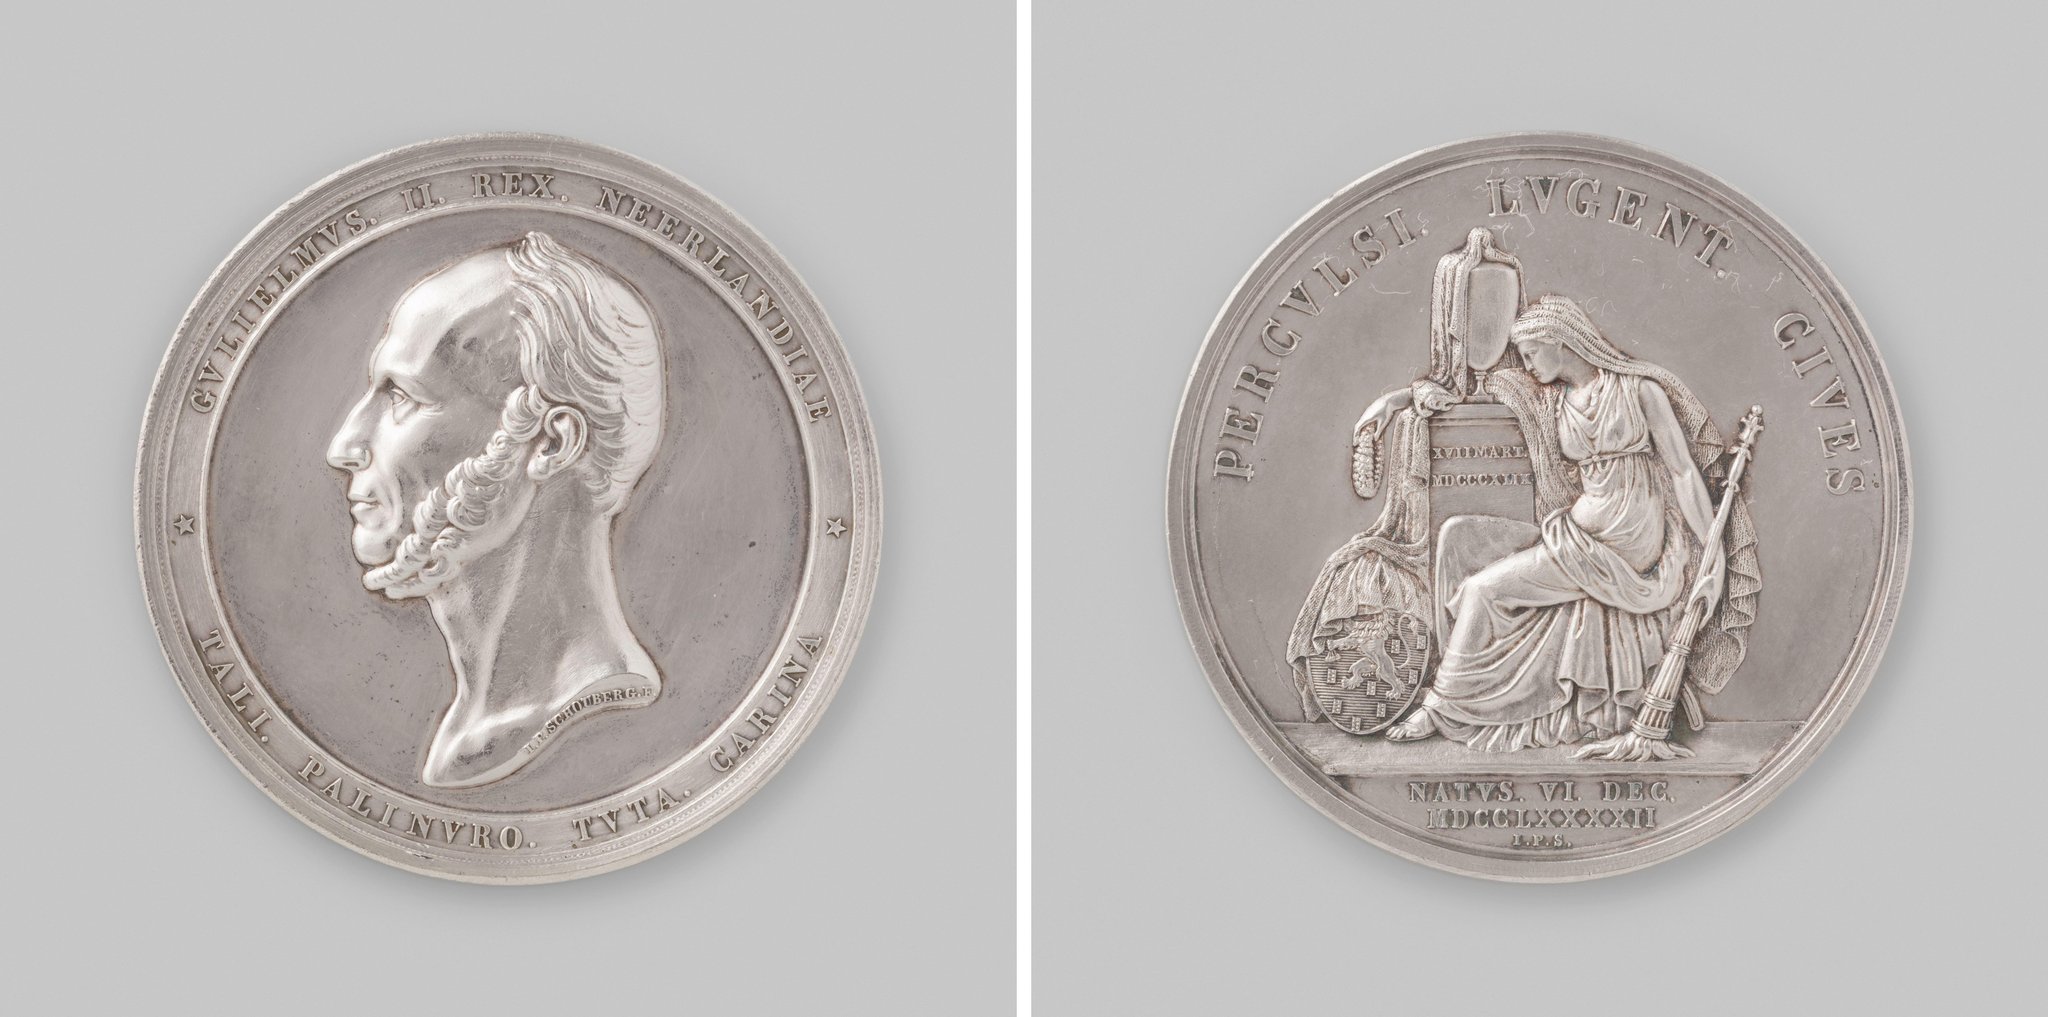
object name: history medal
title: Overlijden van Willem II, koning der Nederlanden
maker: johannis petrus schouberg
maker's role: die cutter, draughtsman, print maker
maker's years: 1798-1864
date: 1849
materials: silver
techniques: striking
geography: utrecht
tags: william ii of the netherlands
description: Zilveren penning. Voorzijde: borststuk man binnen omschrift. Keerzijde: gesluierde vrouw met omgekeerde,gedoofde fakkel in linker- en krans in rechterhand, zit rouwend naast sokkel waaroplijkbus staat, waarom zij haar rechterarm slaat binnen omschrift; afsnede: opschrift